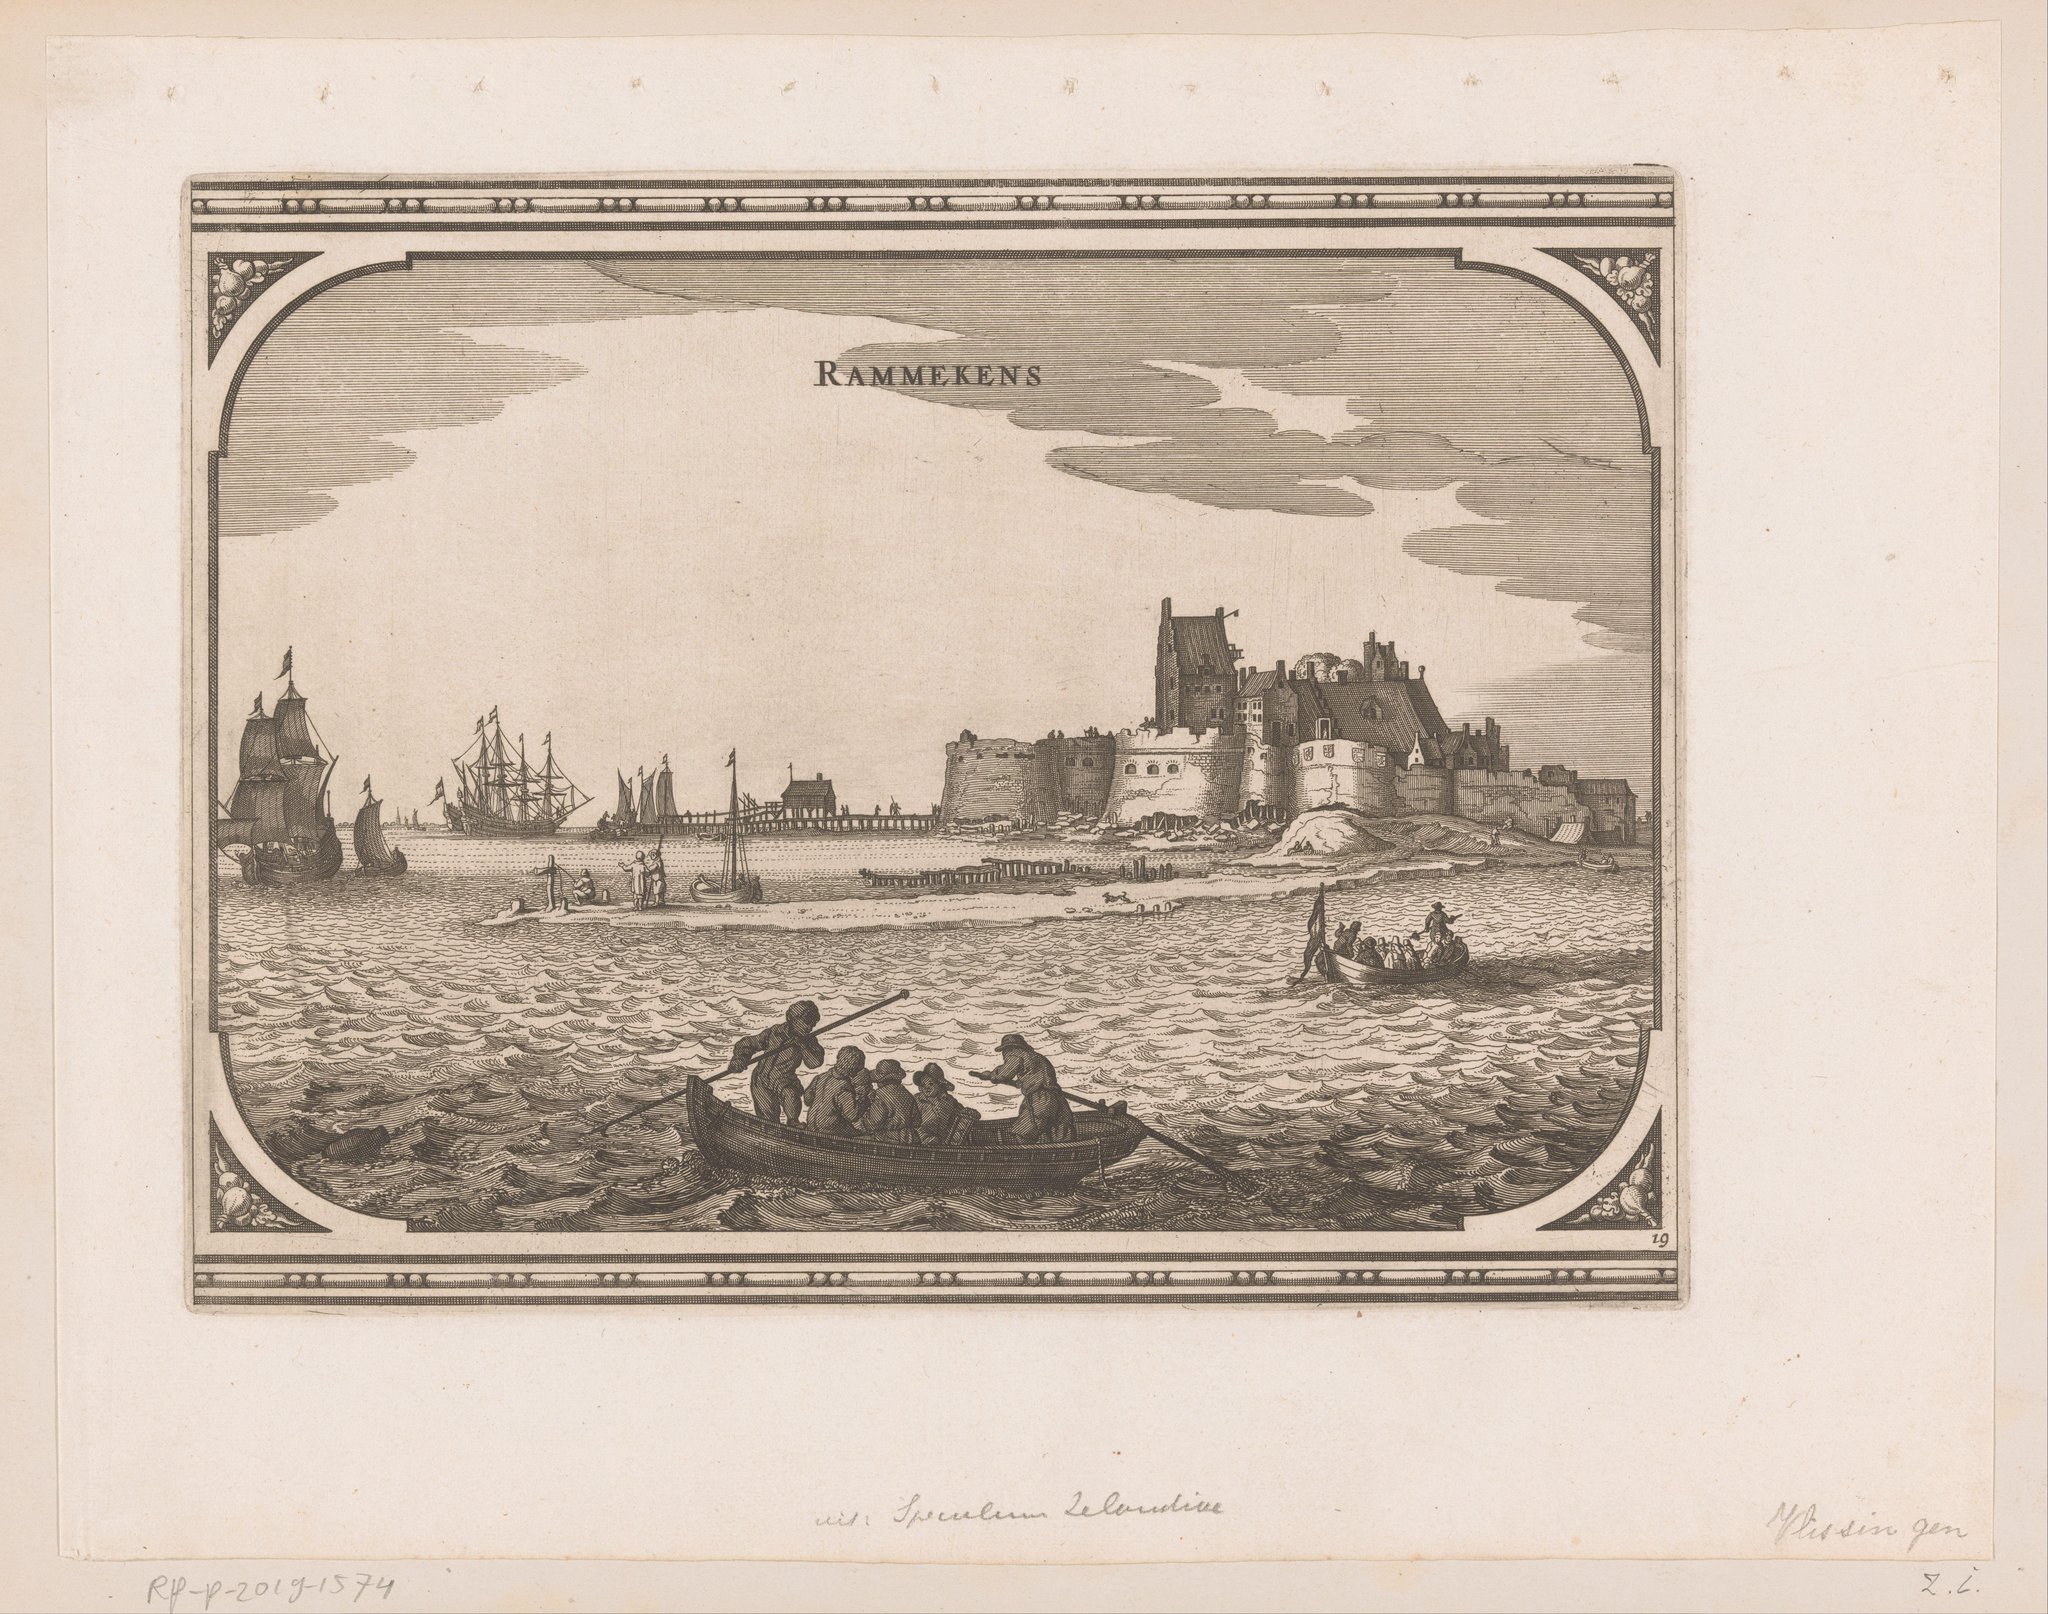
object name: print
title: Speculum Zelandiae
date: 1662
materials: paper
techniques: etching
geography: netherlands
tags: fortress, landscapes with waters, waterscapes, seascapes (in the temperate zone) (+ landscape with figures, staffage)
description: Prent uit: Speculum Zelandiae dat is: een beschryvinge ofte afbeelding der steden (...). Amsterdam: Nicolaes Visscher (I), 1662. Prent in eerdere staat gebruikt in: Theatrum praecipuarum urbium ducatus Brabantiae necnon comitatuum Flandriae et Zelandiae. Amsterdam: Nicolaes Visscher (I), 1657